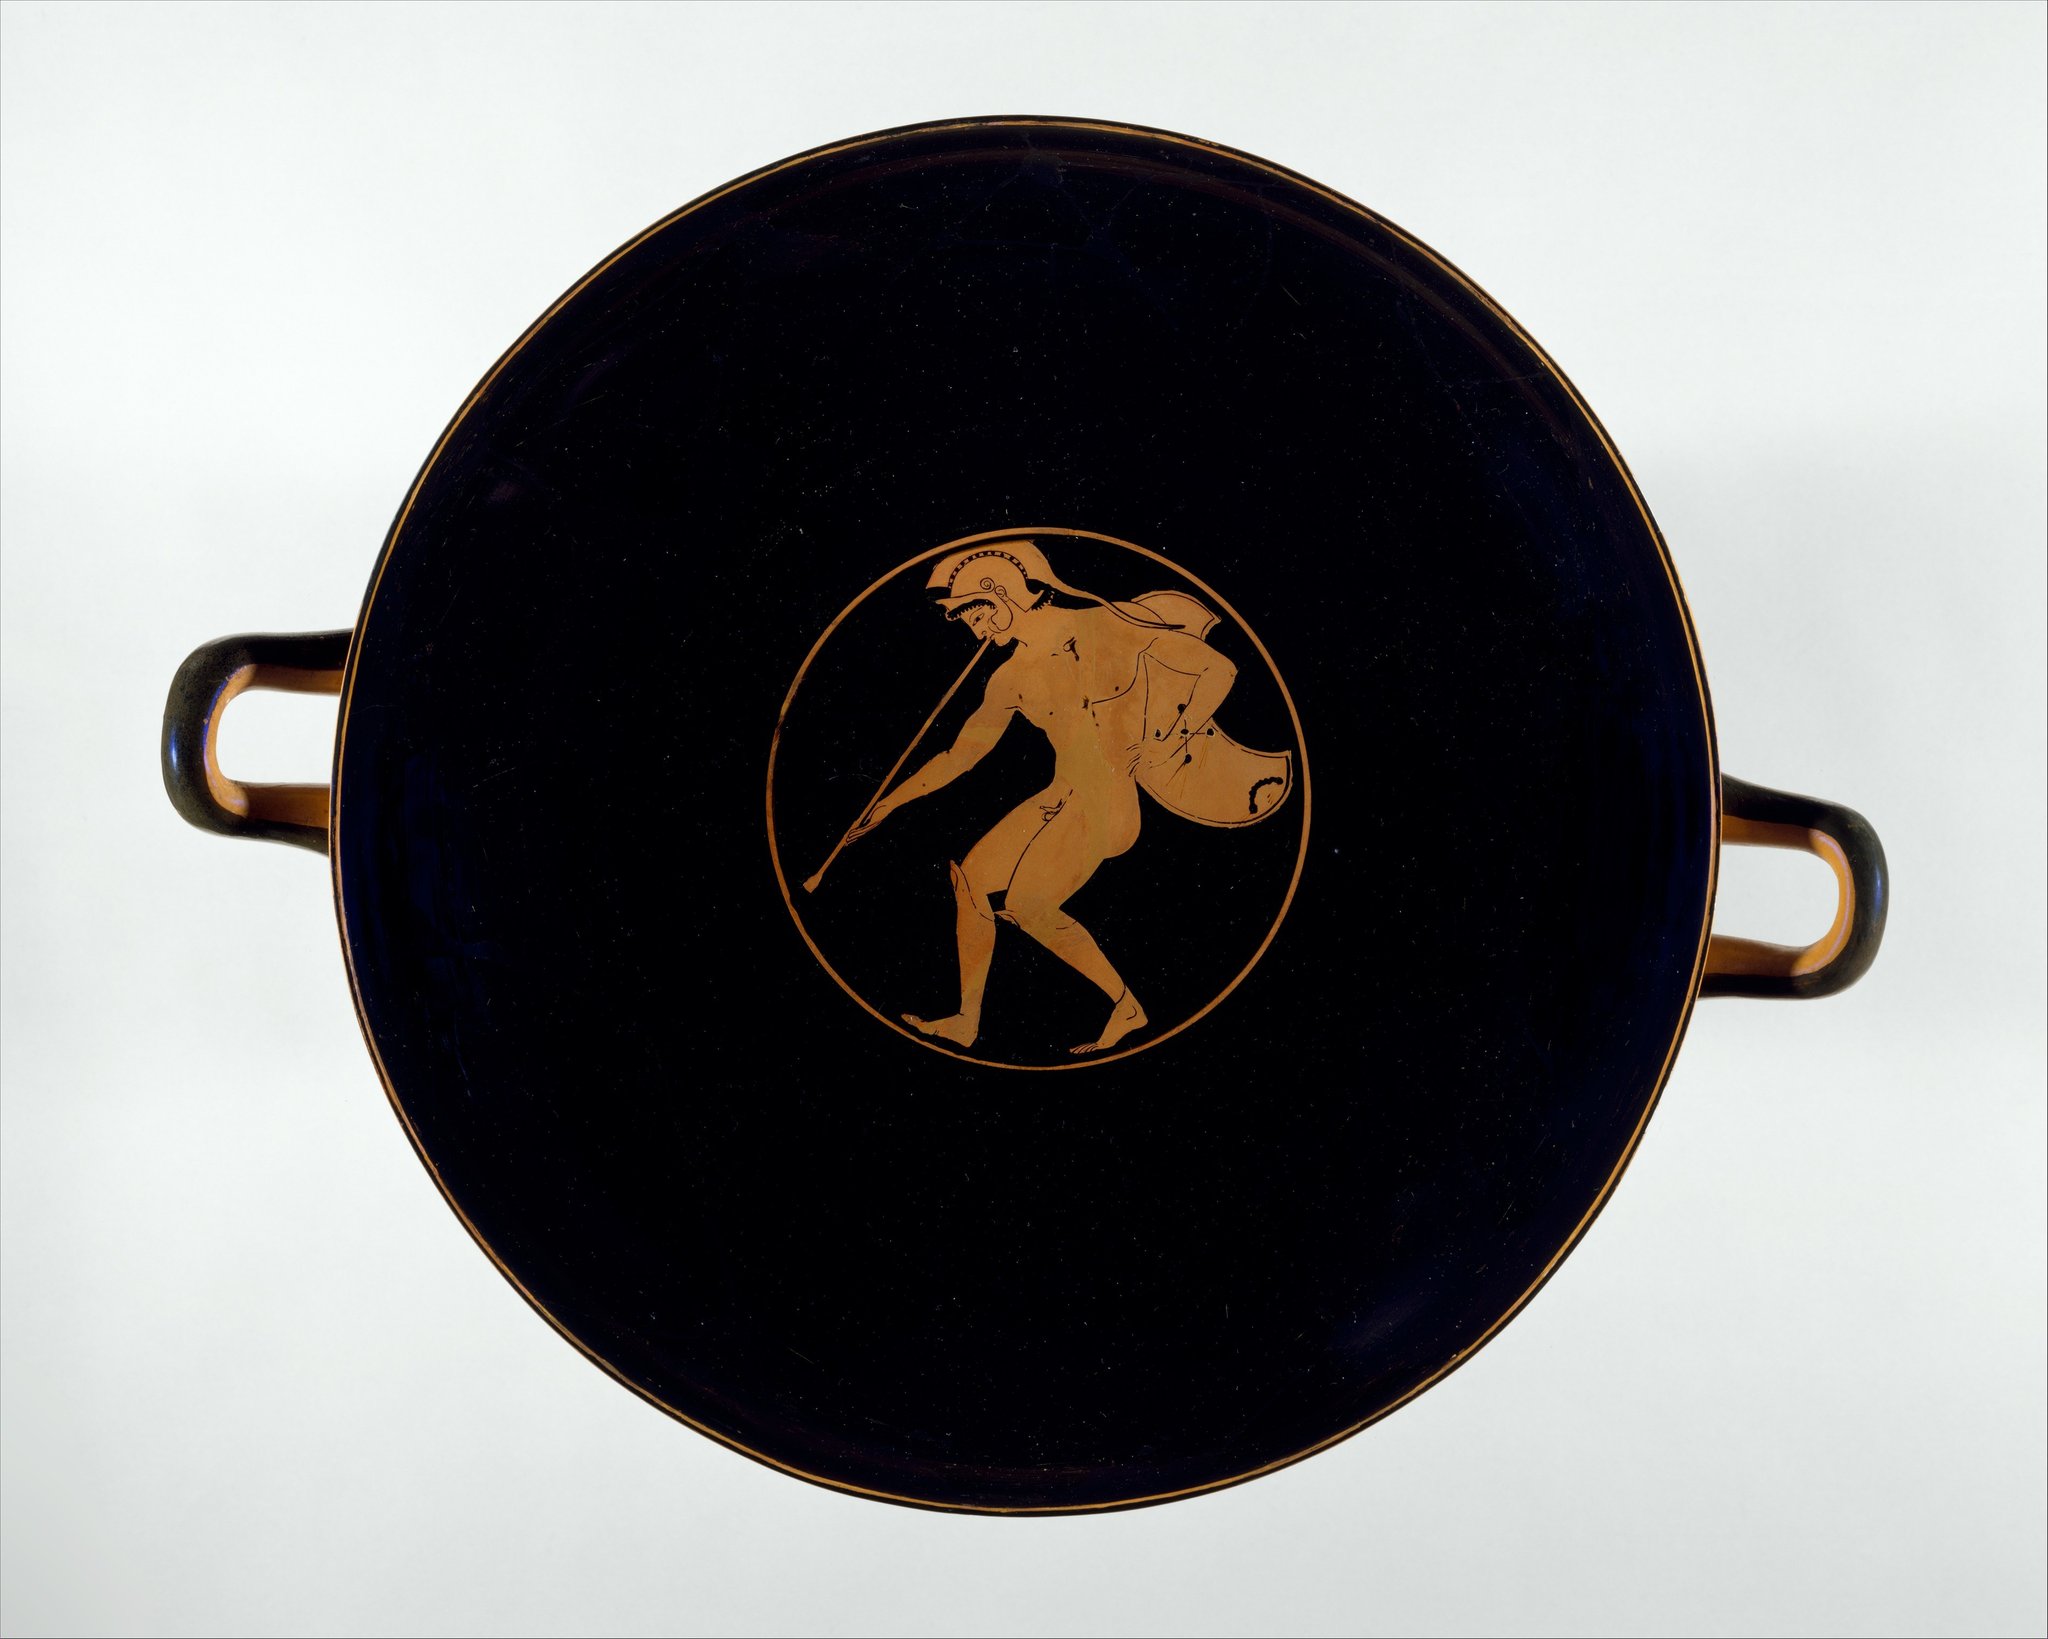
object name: kylix, type b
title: Terracotta kylix (drinking cup)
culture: greek, attic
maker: ashby painter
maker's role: artist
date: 500 BCE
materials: terracotta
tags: men,male nudes,flutes,trumpets